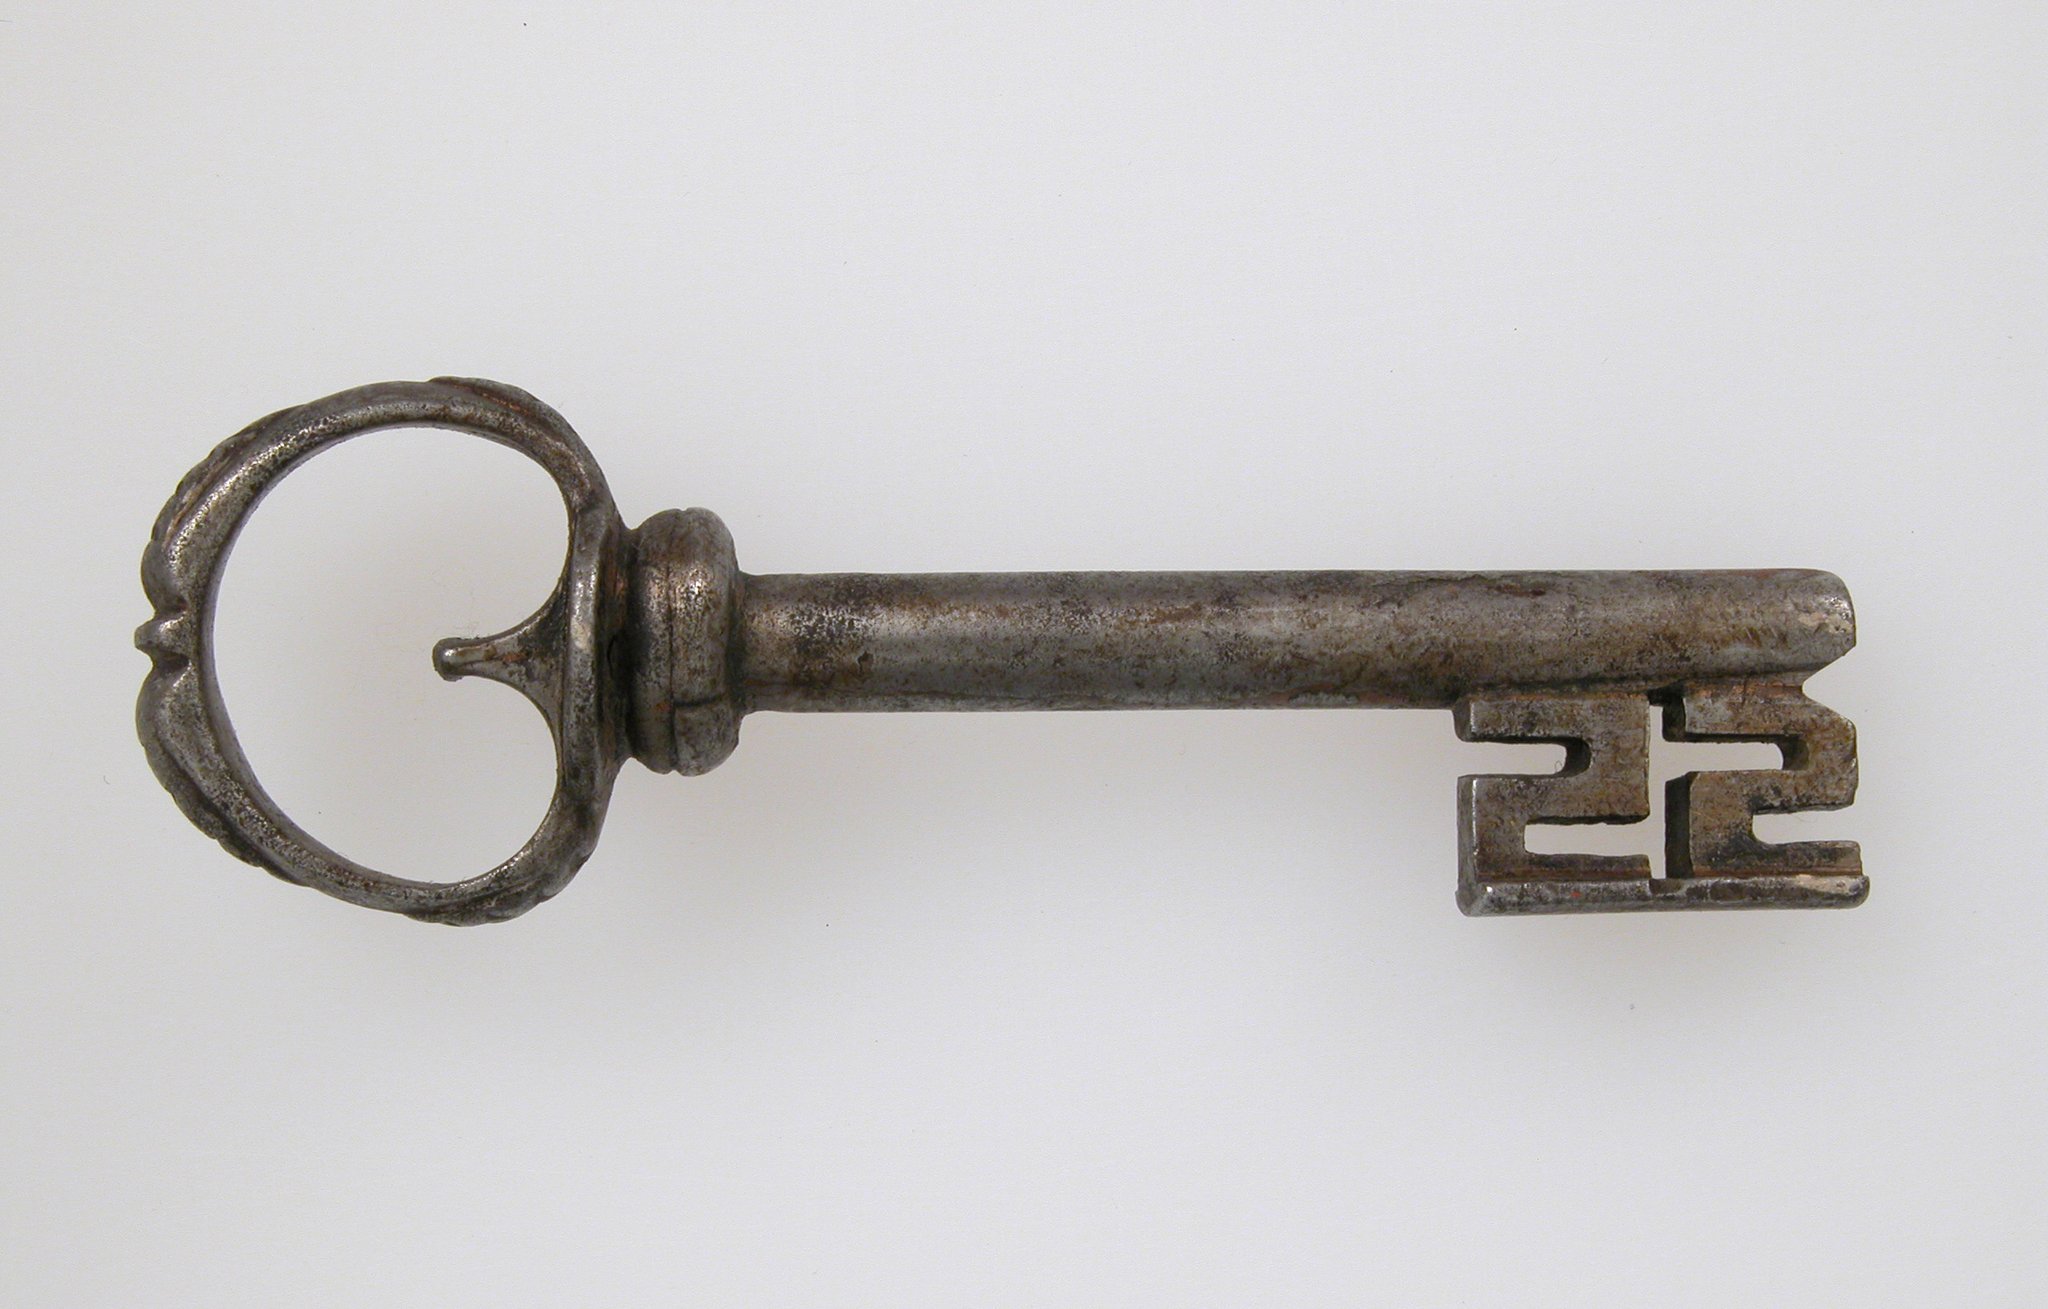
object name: key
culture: german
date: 1401-1500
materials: iron